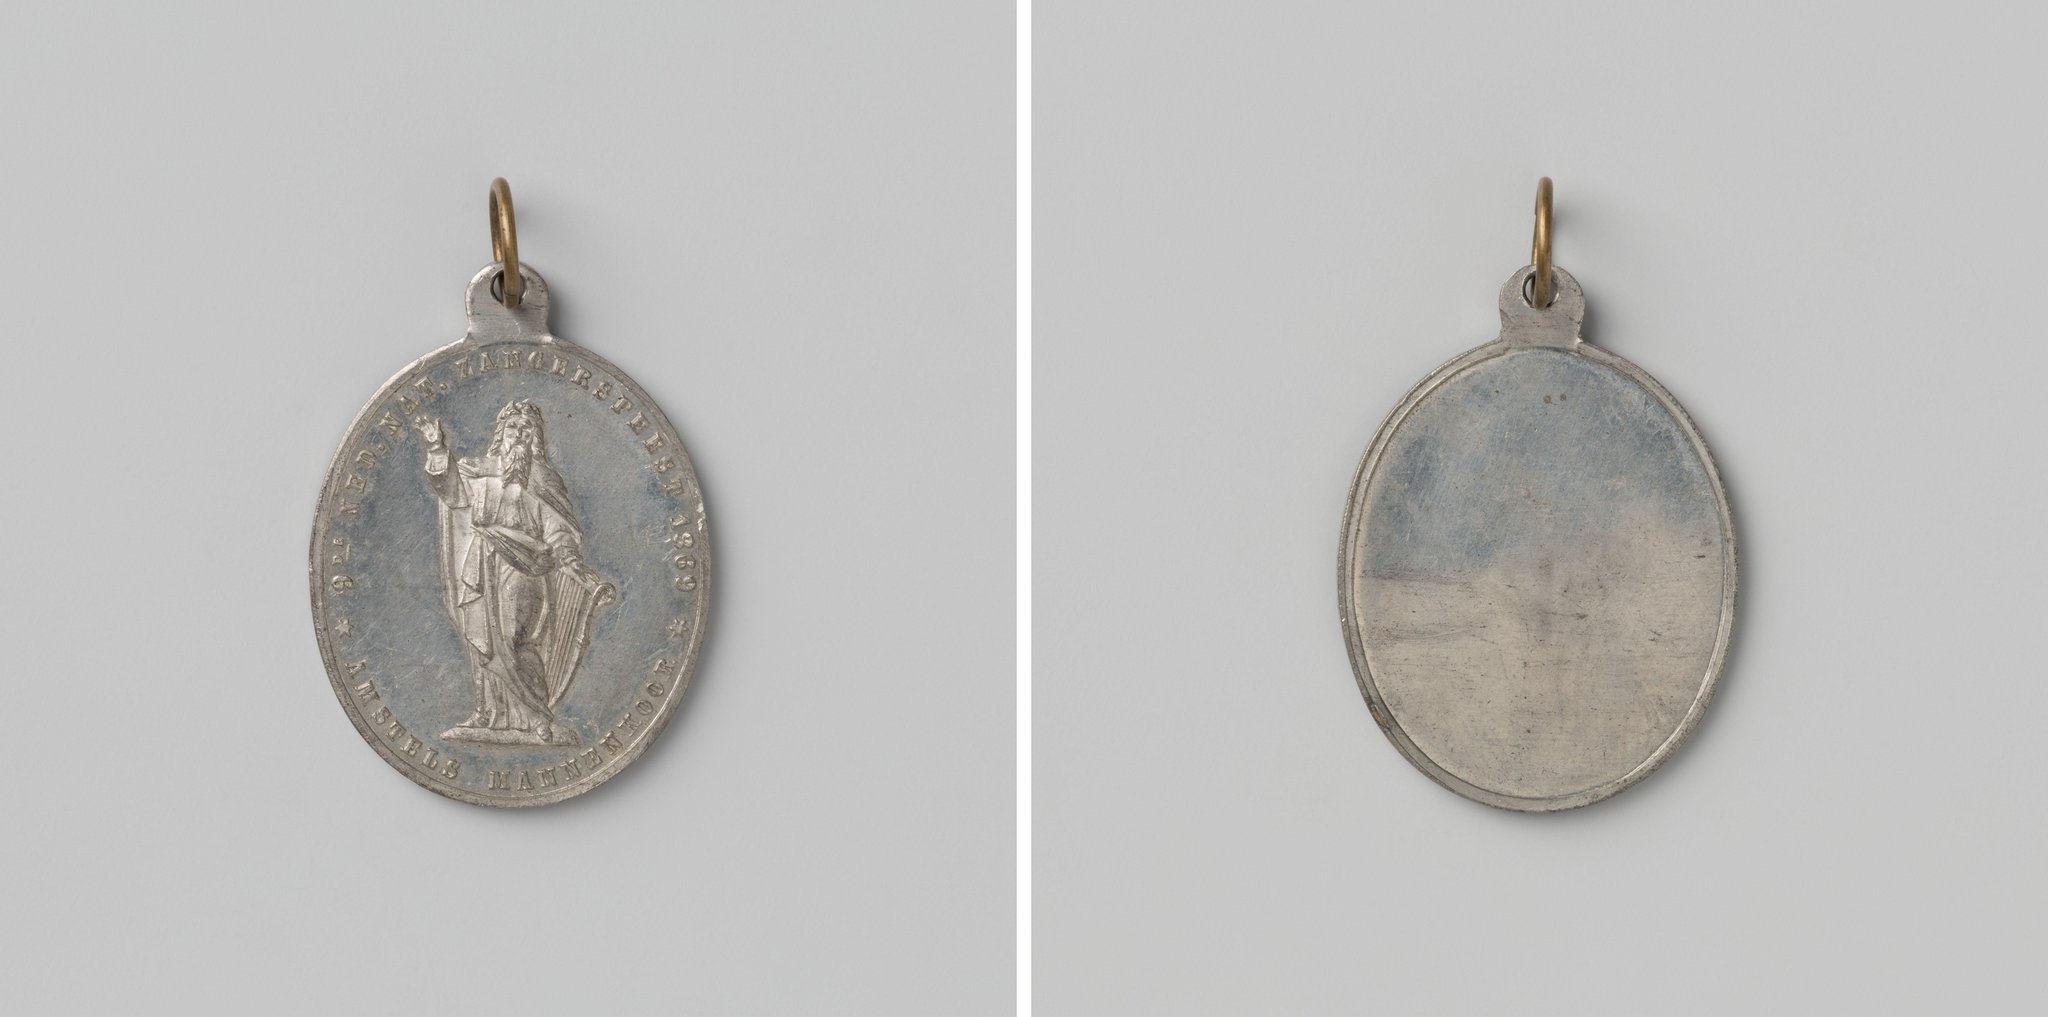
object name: medal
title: Negende Nederlandsch nationaal zangersfeest te Amsterdam, georganiseerd door het Amstels mannenkoor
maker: Anonymous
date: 1869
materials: tin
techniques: striking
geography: amsterdam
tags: amsterdam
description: Eenzijdige tinnen penning aan draagoog en draagring. Voorzijde: david met opgeheven rechetrhand en met linkerhand op naast hem staande harp binnen omschrift. Keerzijde: blanco.